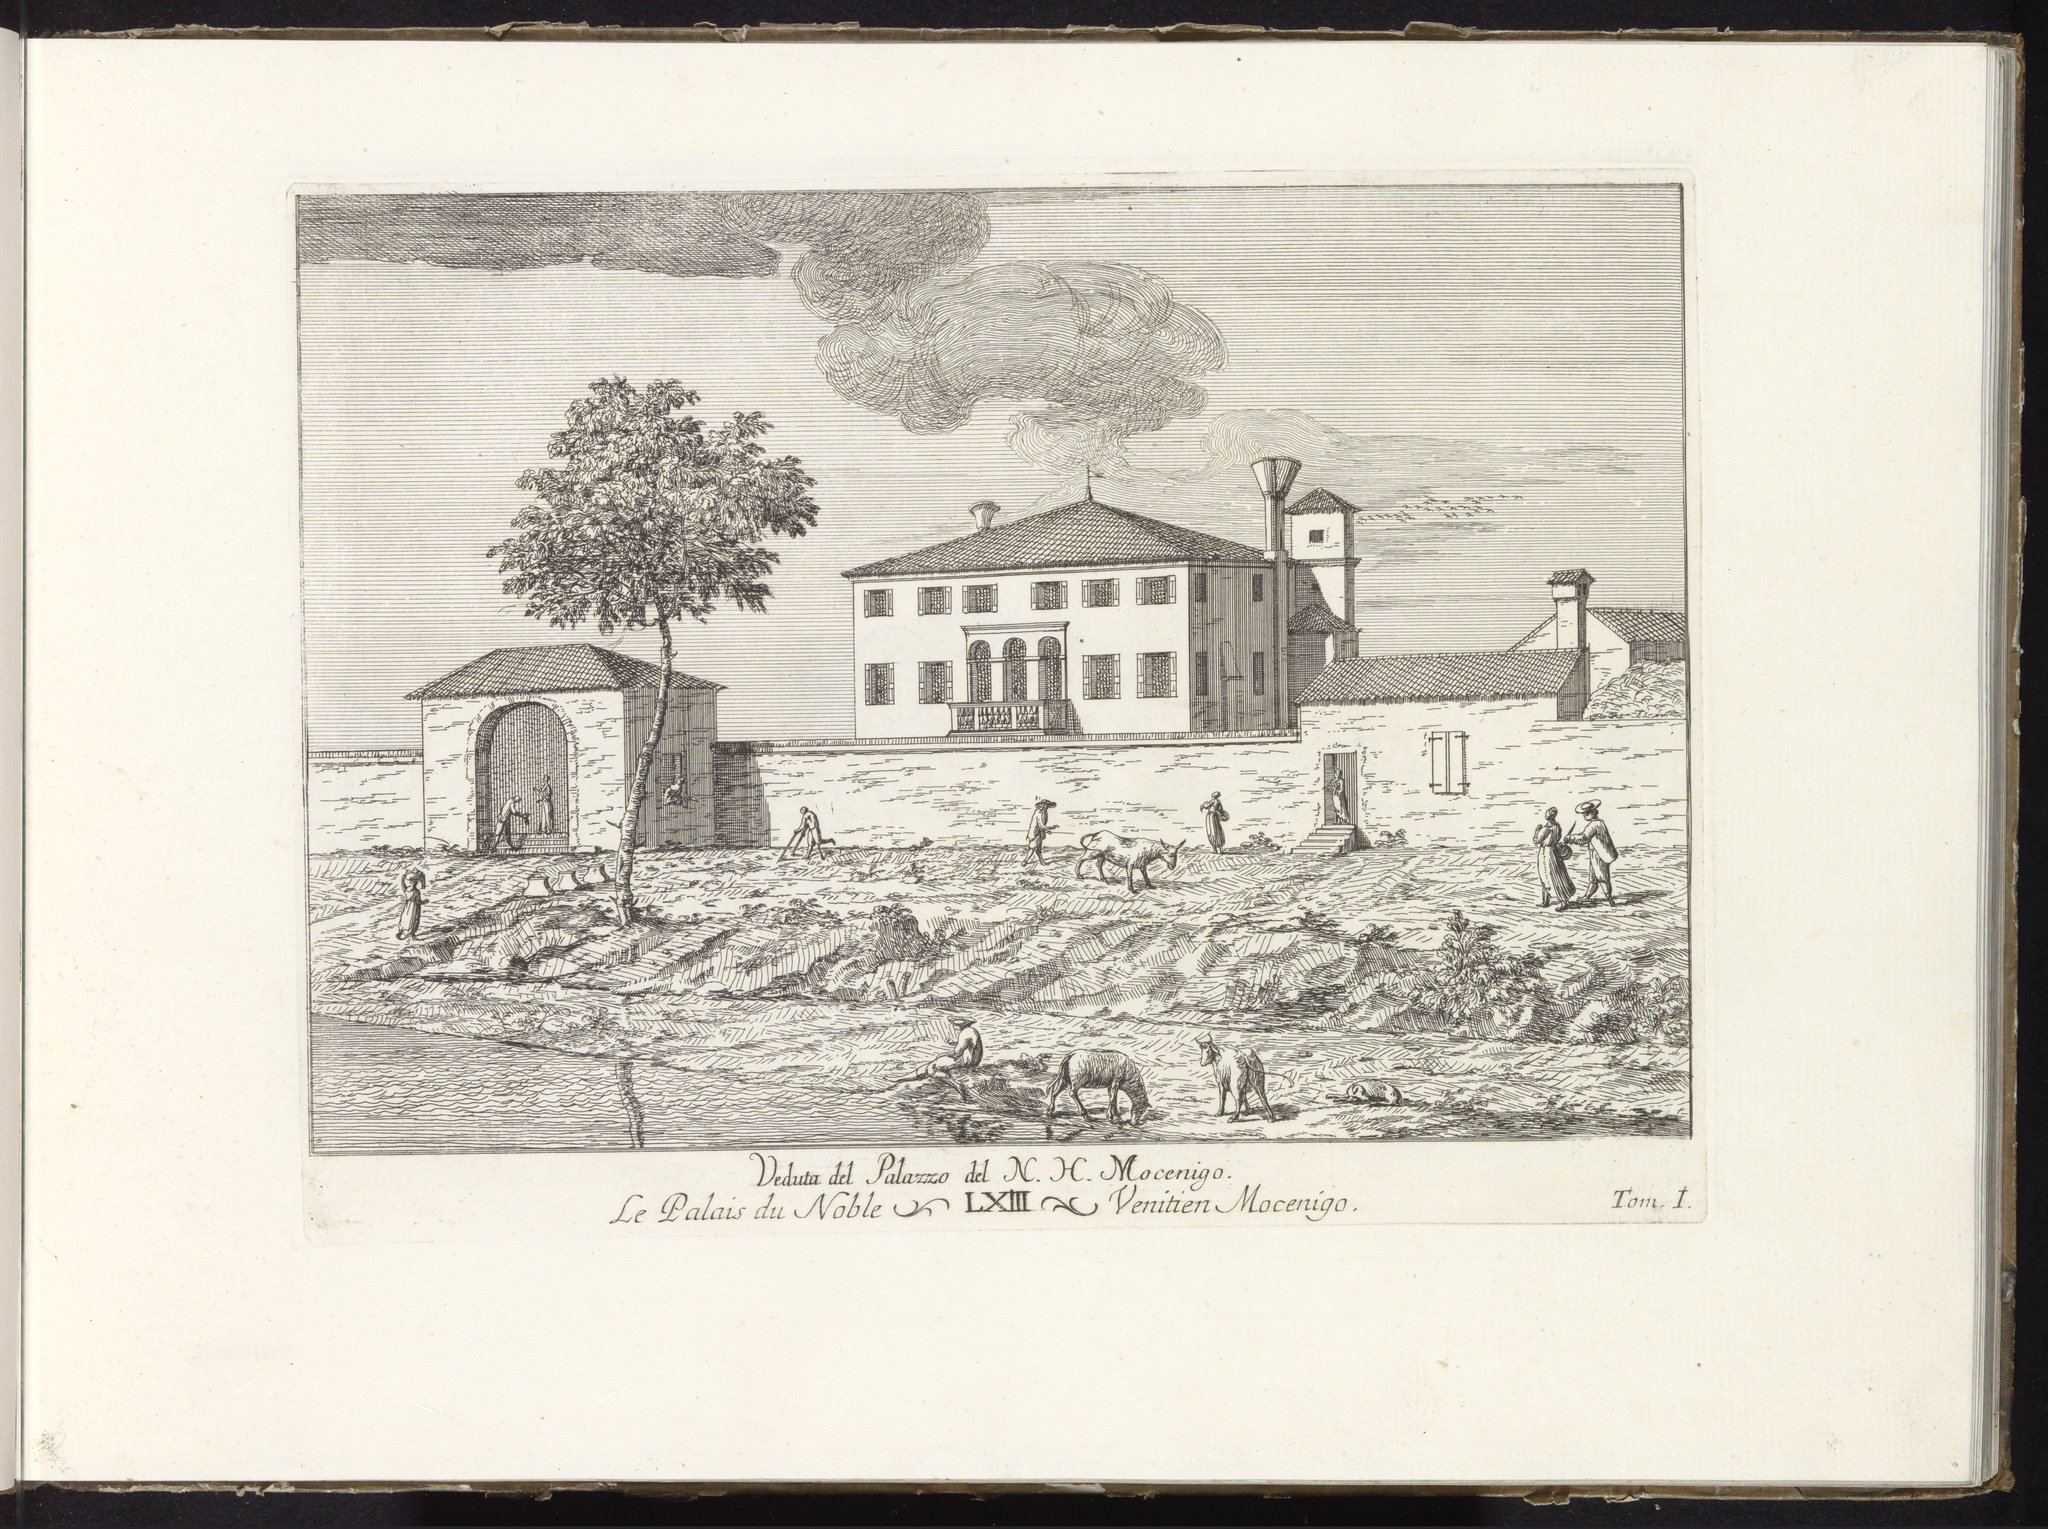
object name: print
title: Le delicie della Brenta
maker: giovanni francesco costa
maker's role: draughtsman, painter, print maker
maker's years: -1773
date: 1750-1760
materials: paper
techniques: etching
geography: italy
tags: river, herding, herdsman, herdswoman, shepherd, shepherdess, cowherd, etc., hôtel, i.e. small palace in city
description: Gezicht op Palazzo del N. H. Mocenigo aan de rivier de Brenta. Aan de waterkant zit een rustende herder met twee koeien en een hond. Genummerd midden onder: LXIII en rechtsonder: Tom: I. Deze prent maakt deel uit van een album.